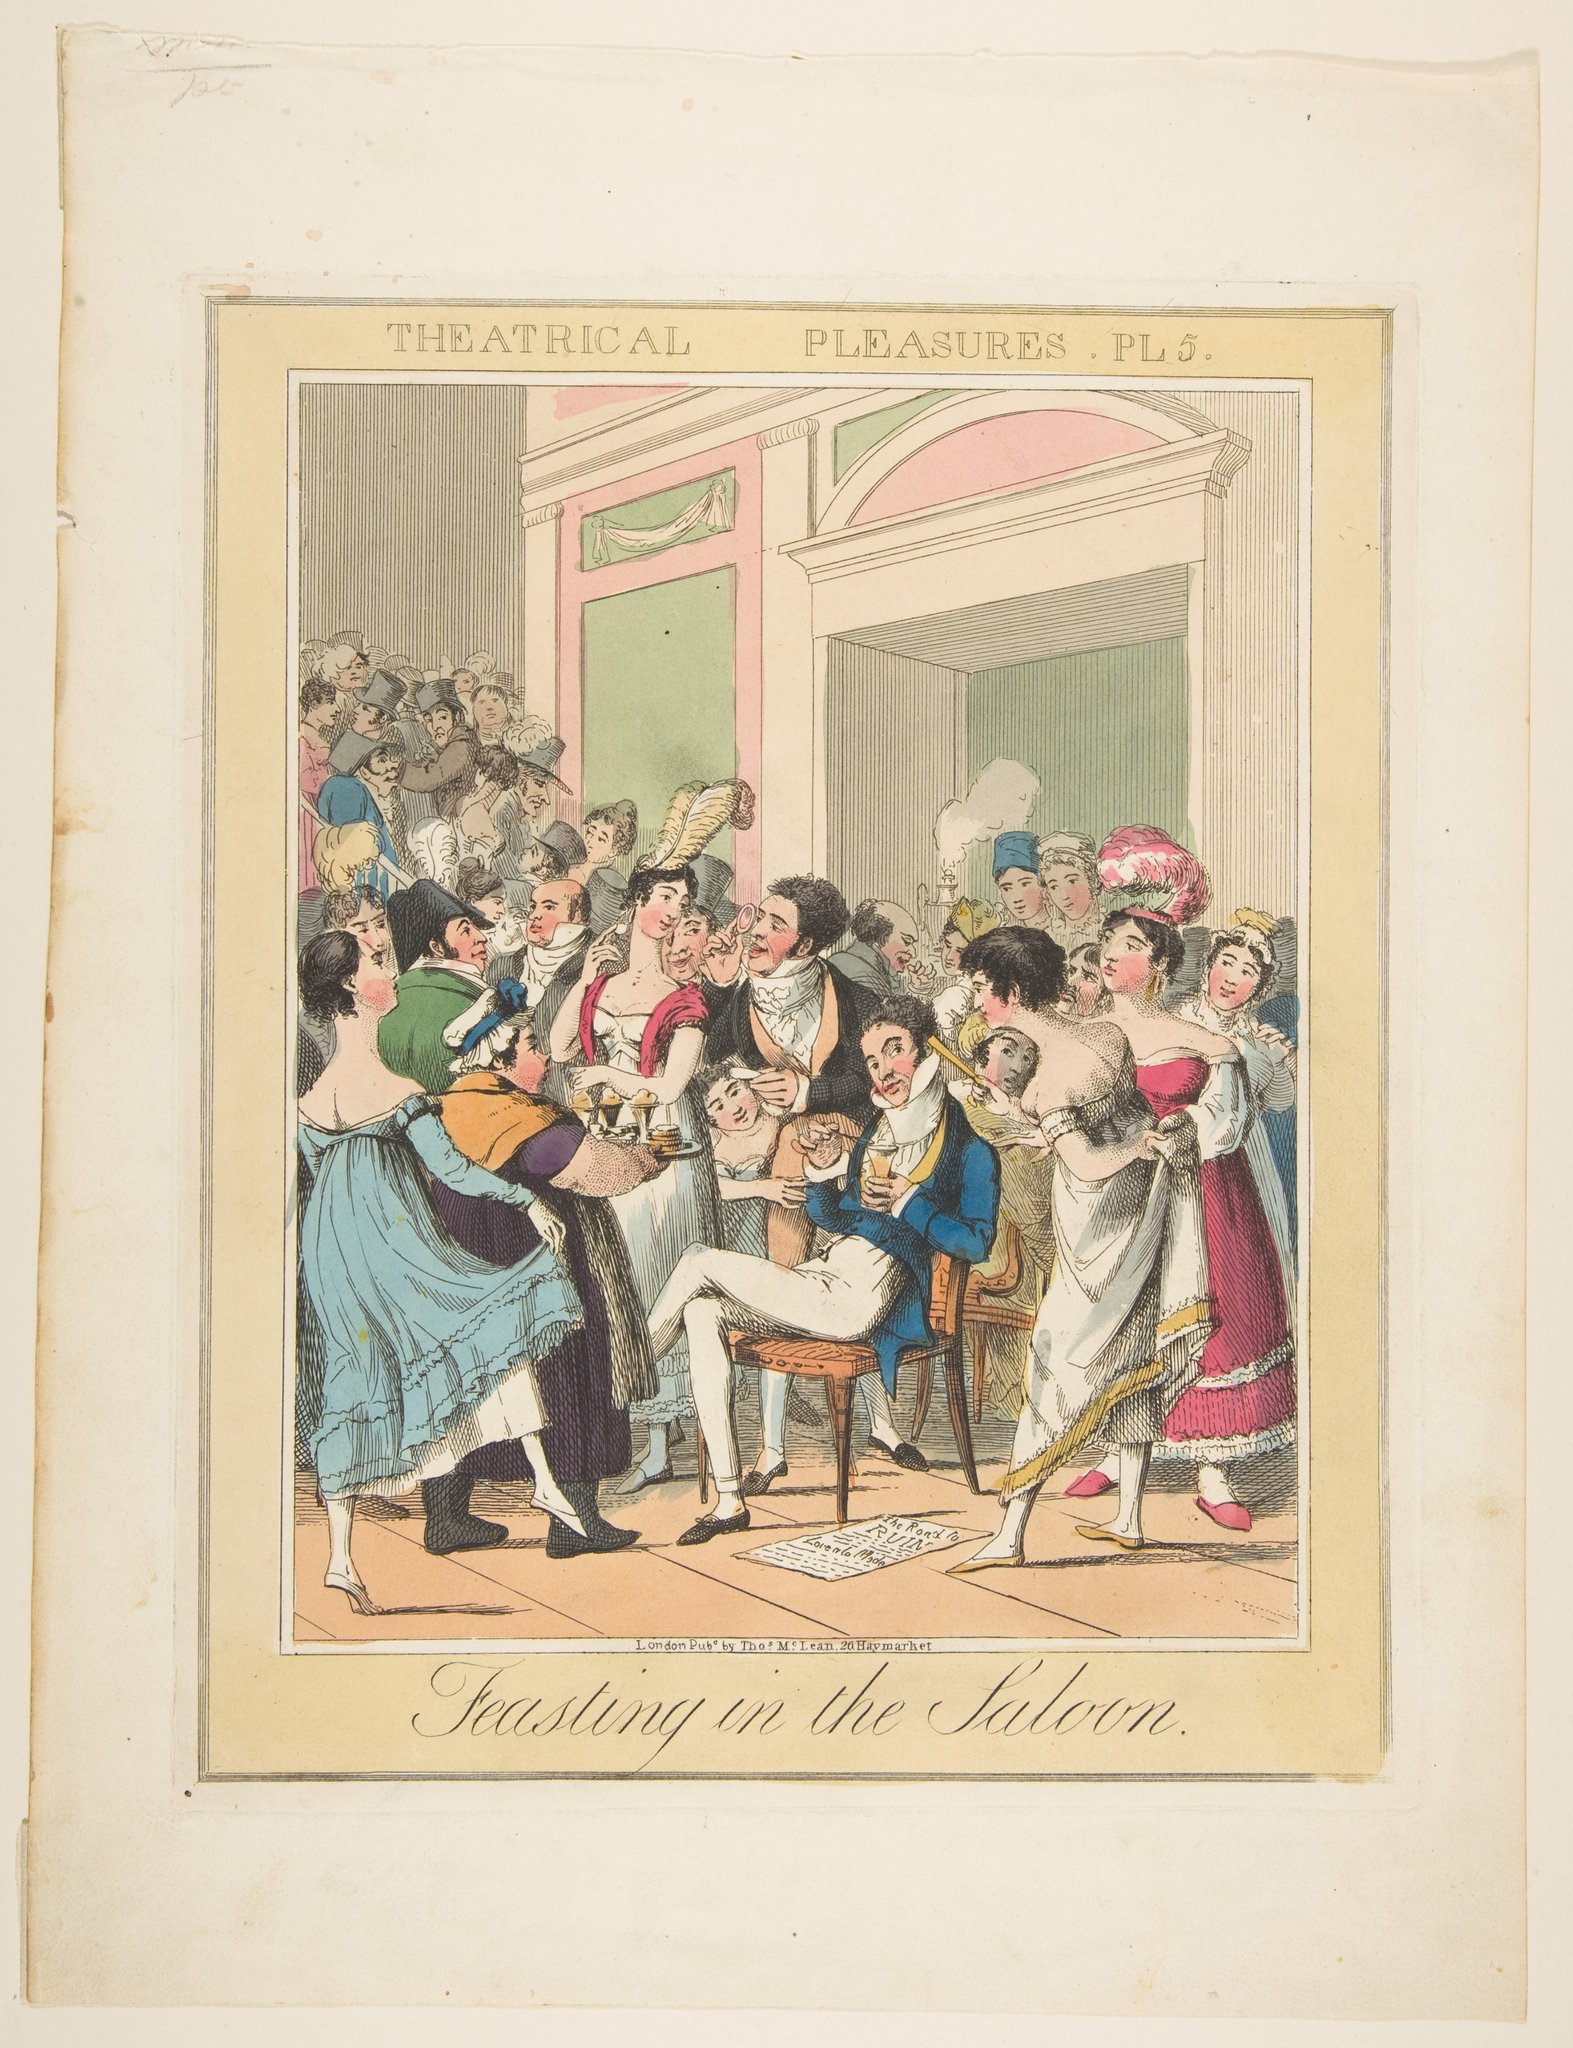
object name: print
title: Theatrical Pleasures, Plate 5: Feasting in the Saloon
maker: theodore lane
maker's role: artist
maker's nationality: british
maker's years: 1800-1828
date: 1835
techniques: etching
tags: men,women